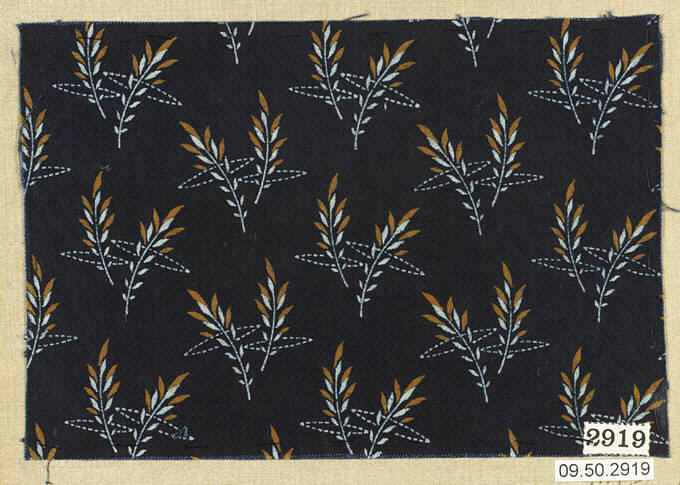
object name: piece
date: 1801-1900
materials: cotton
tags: leaves